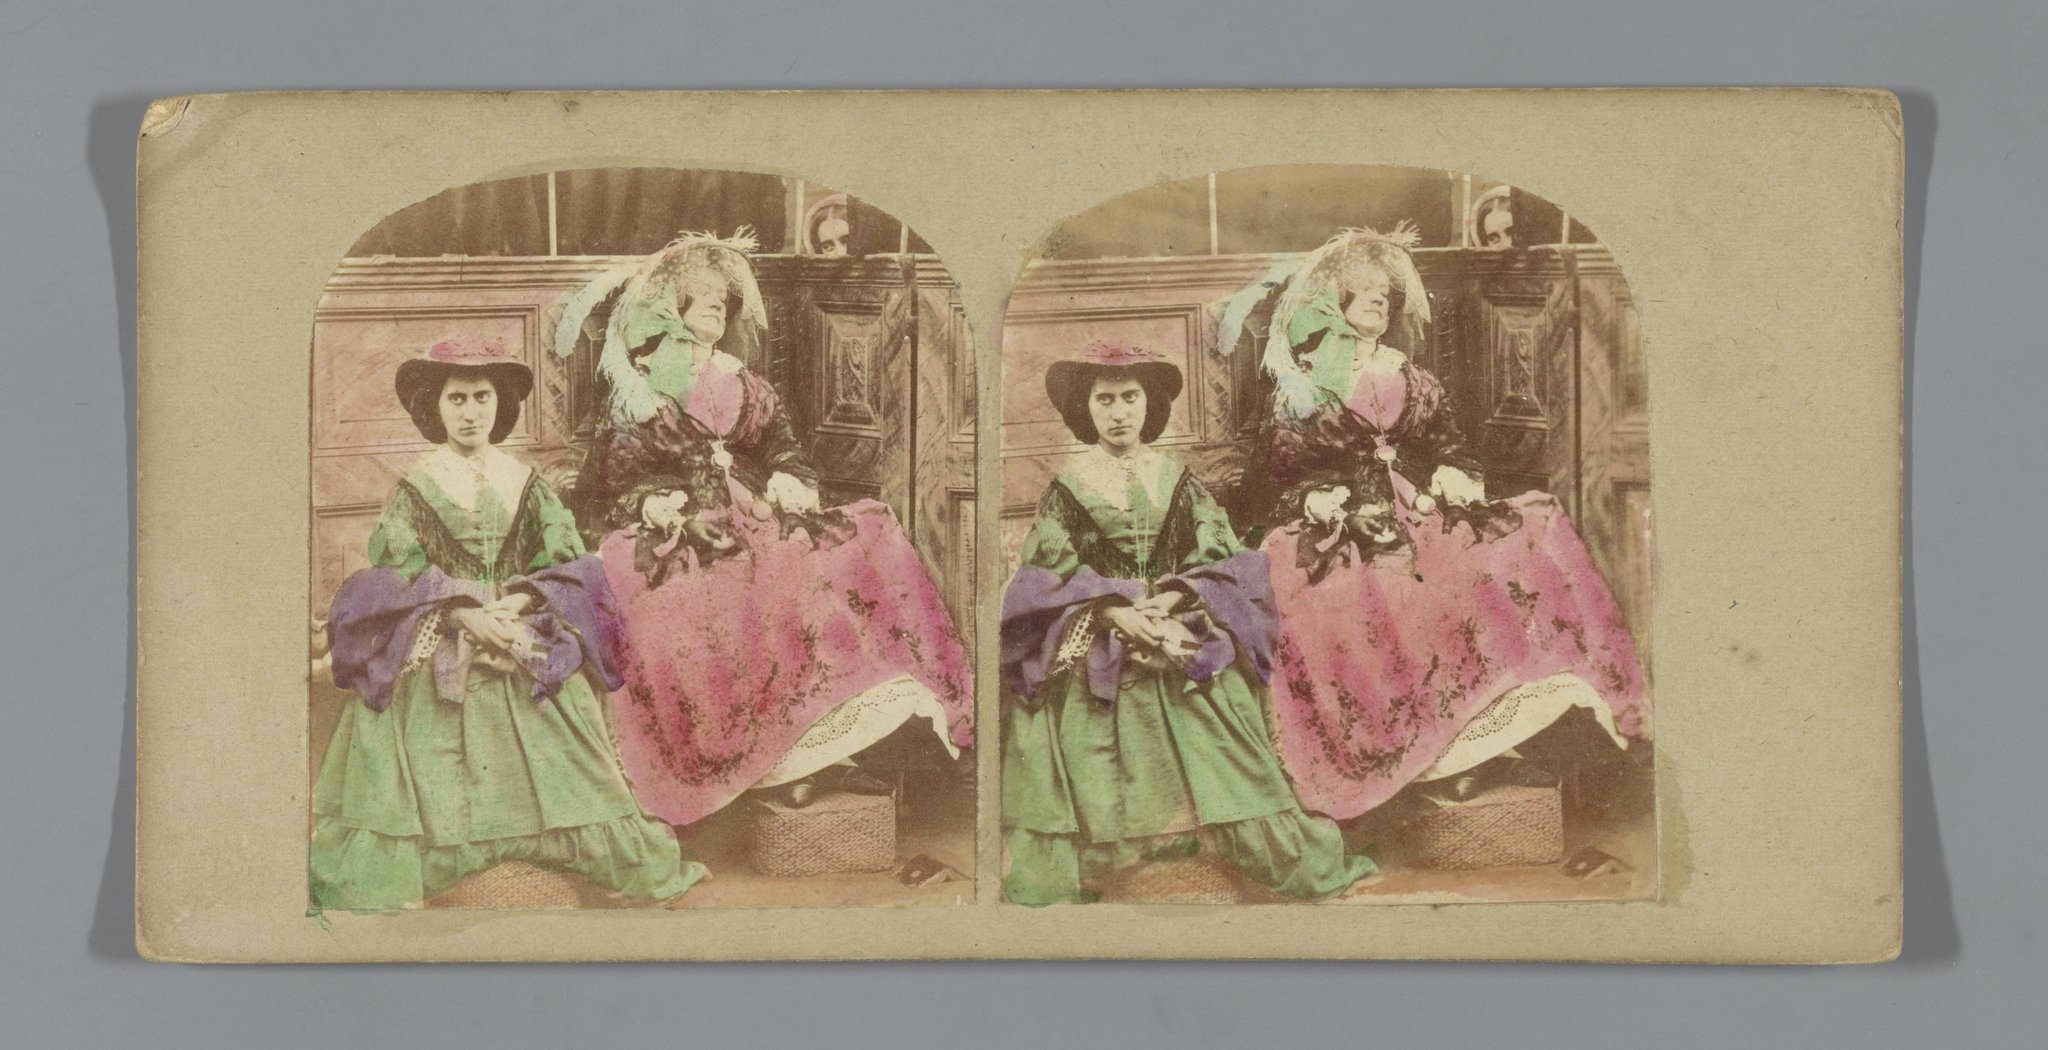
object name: stereograph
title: Twee vrouwen worden begluurd door een derde vrouw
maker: Anonymous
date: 1852-1863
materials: cardboard, paper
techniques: albumen print, hand coloring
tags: sleeping; unconsciousness